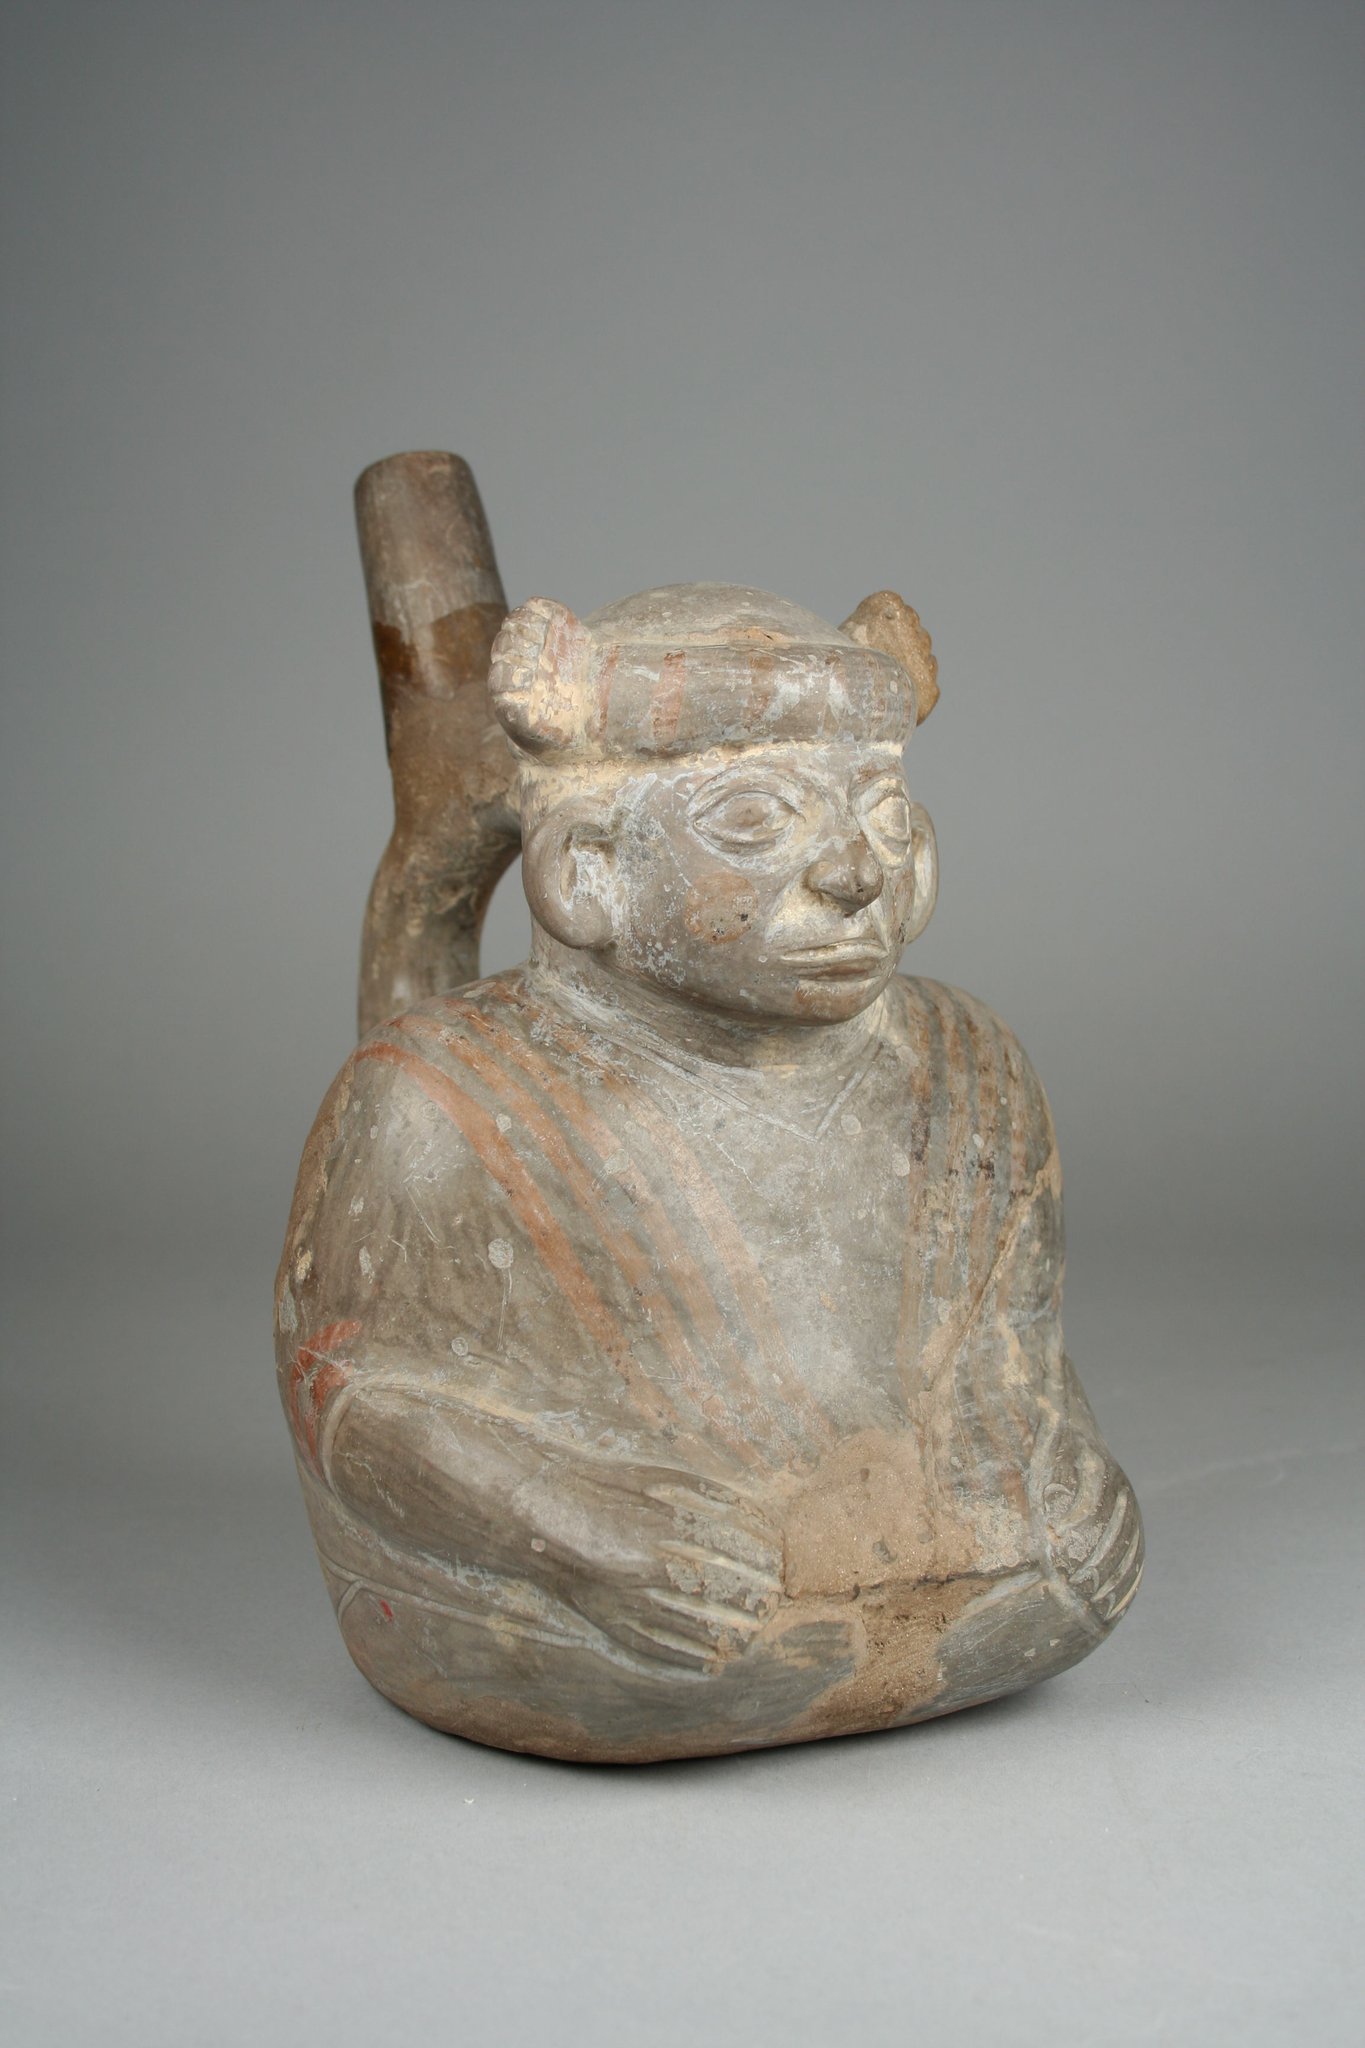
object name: bottle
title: Stirrup Spout Bottle with Seated Figure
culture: moche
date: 200-1 BCE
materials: ceramic, pigment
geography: peru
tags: human figures